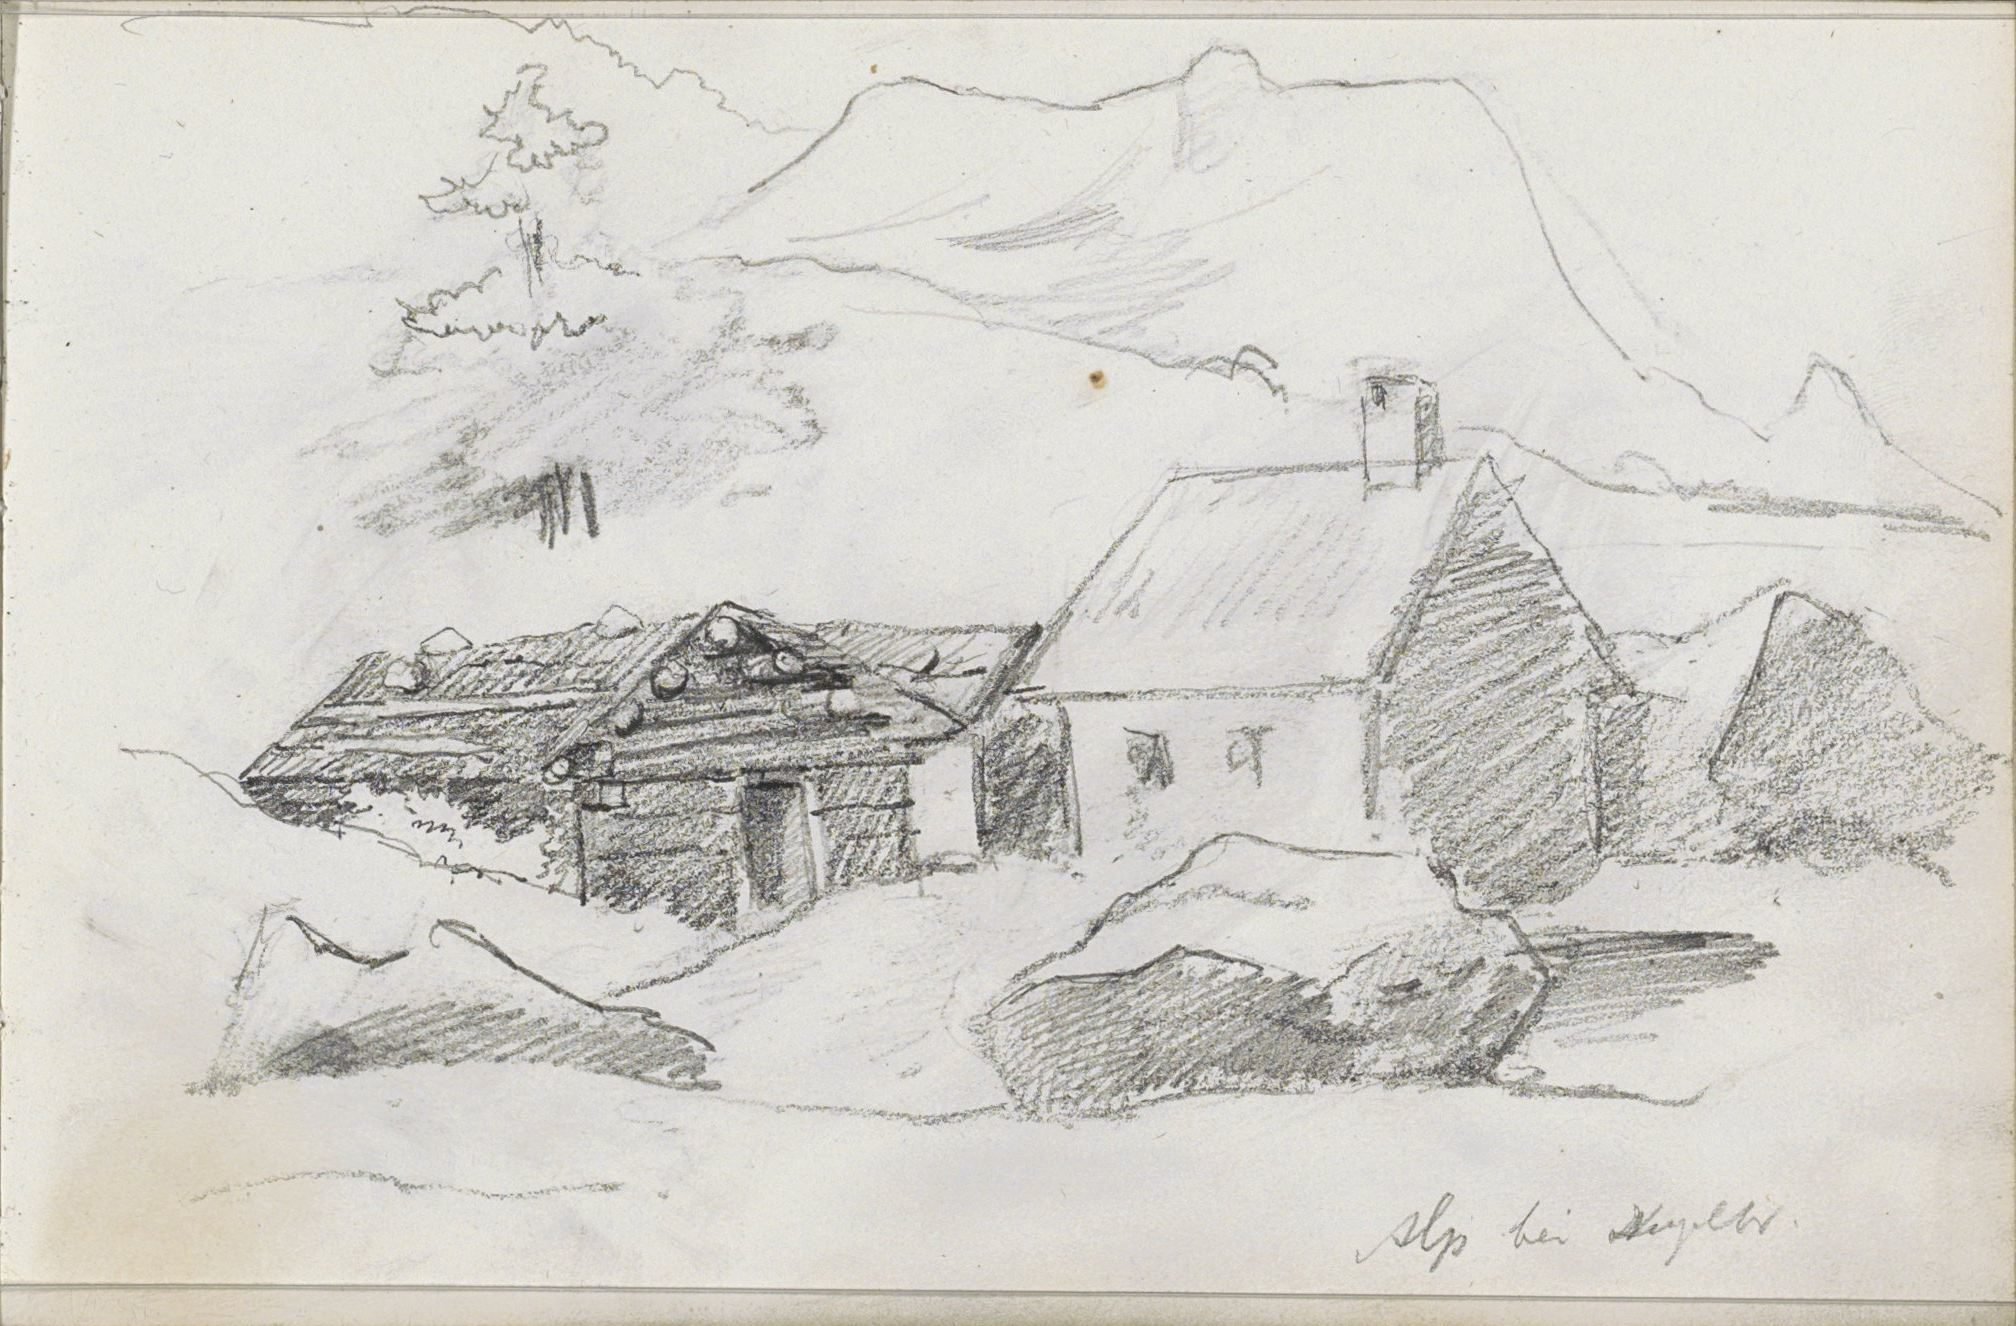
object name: sketchbook leaf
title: Huizen aan de voet van de Alpen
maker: isaac gosschalk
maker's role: draughtsman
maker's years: 1838-1907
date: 1860-1861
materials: paper, pencil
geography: switzerland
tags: mountain-range, snow peaks, switzerland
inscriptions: annotation: ‘Alp bei [...]egelbr’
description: Blad 15 recto uit een schetsboek met 29 bladen.